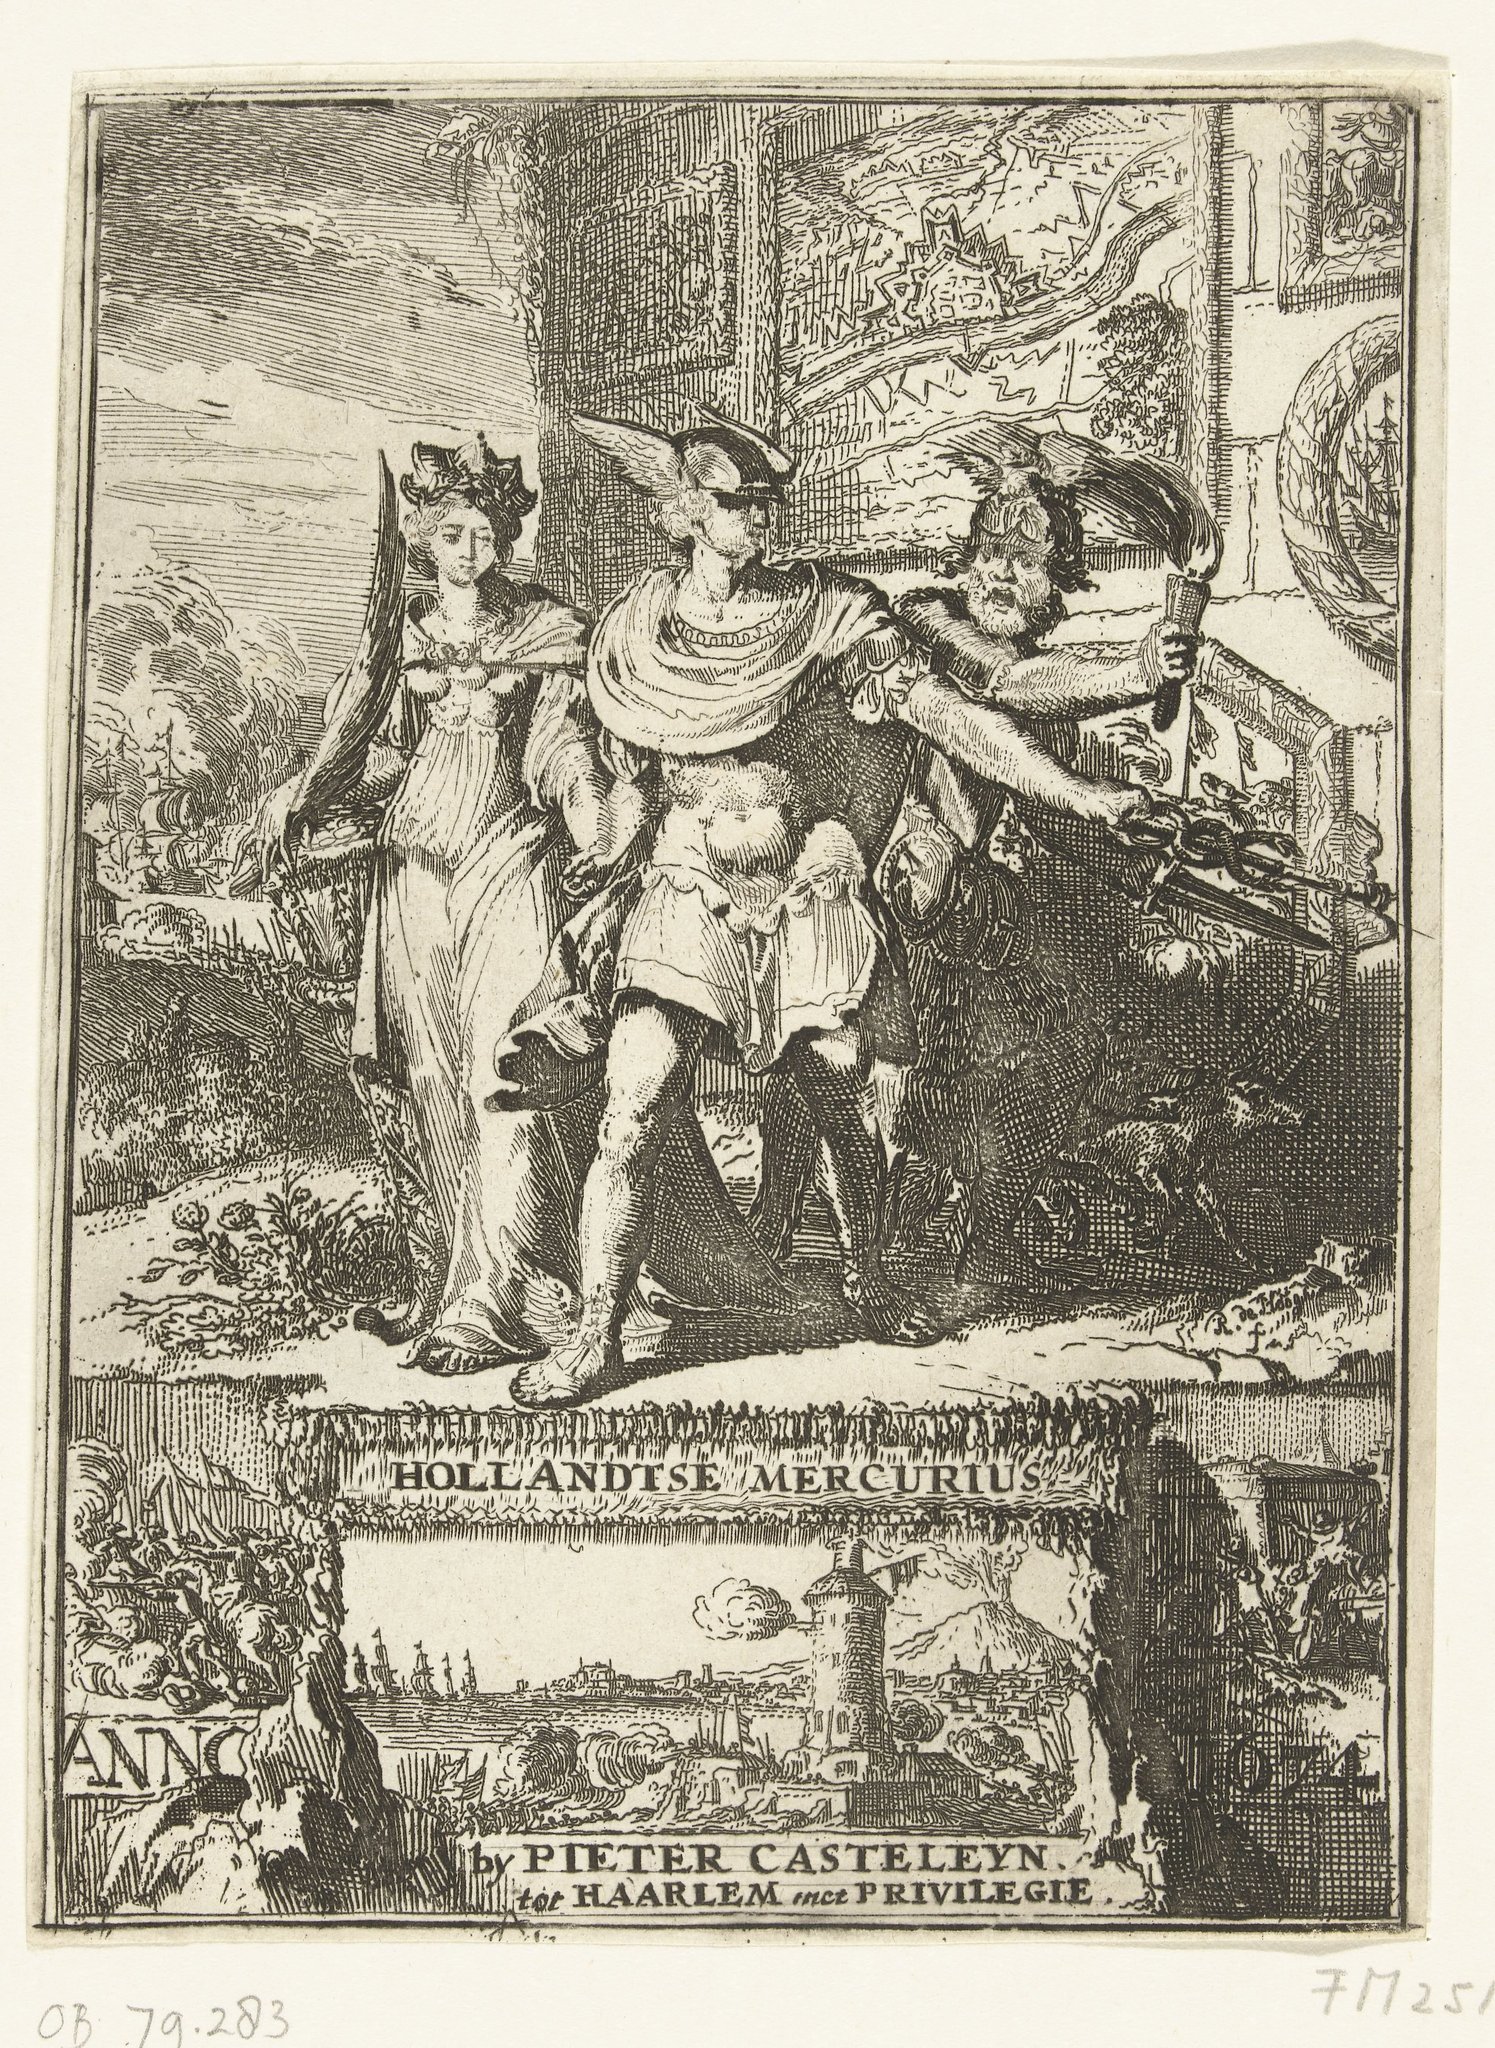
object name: print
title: Titelpagina voor de Hollandsche Mercurius over het jaar 1674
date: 1675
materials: paper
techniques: etching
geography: haarlem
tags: warfare; military affairs (+ naval force), specific aspects, allegorical aspects of mercury; mercury as patron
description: Titelpagina voor de Hollandsche Mercurius over het jaar 1674. Mercurius gearm met de vrouwelijke personificatie van Zeevaart. Onder en boven kleine scènes van zeeslagen en gevechten, een vuurtoren en een plattegrond van vesting.